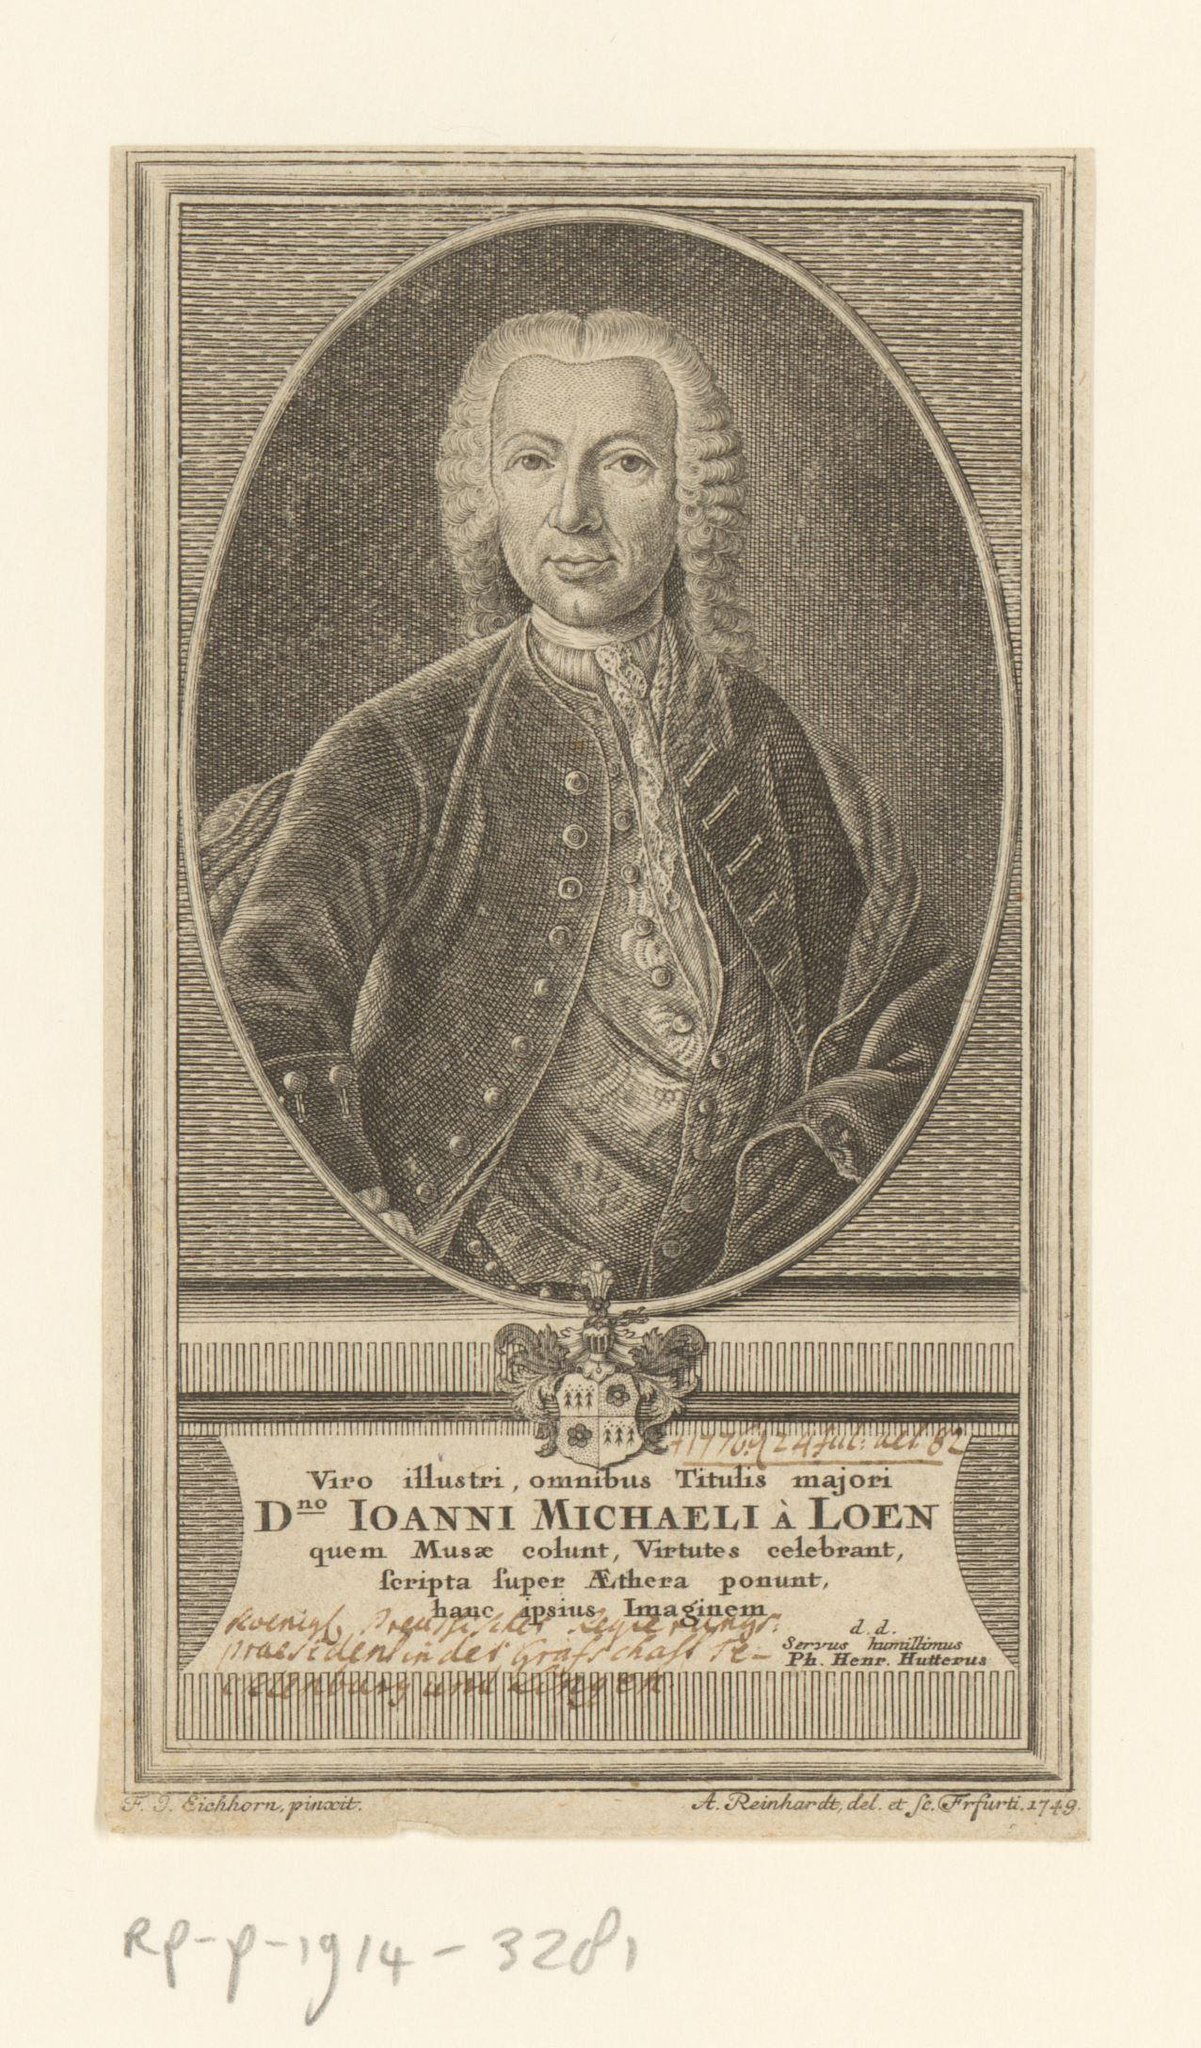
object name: print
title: Portret van Johan Michael von Loën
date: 1749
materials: paper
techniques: engraving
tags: historical persons, armorial bearing, heraldry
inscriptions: collector's mark: Lugt 2228